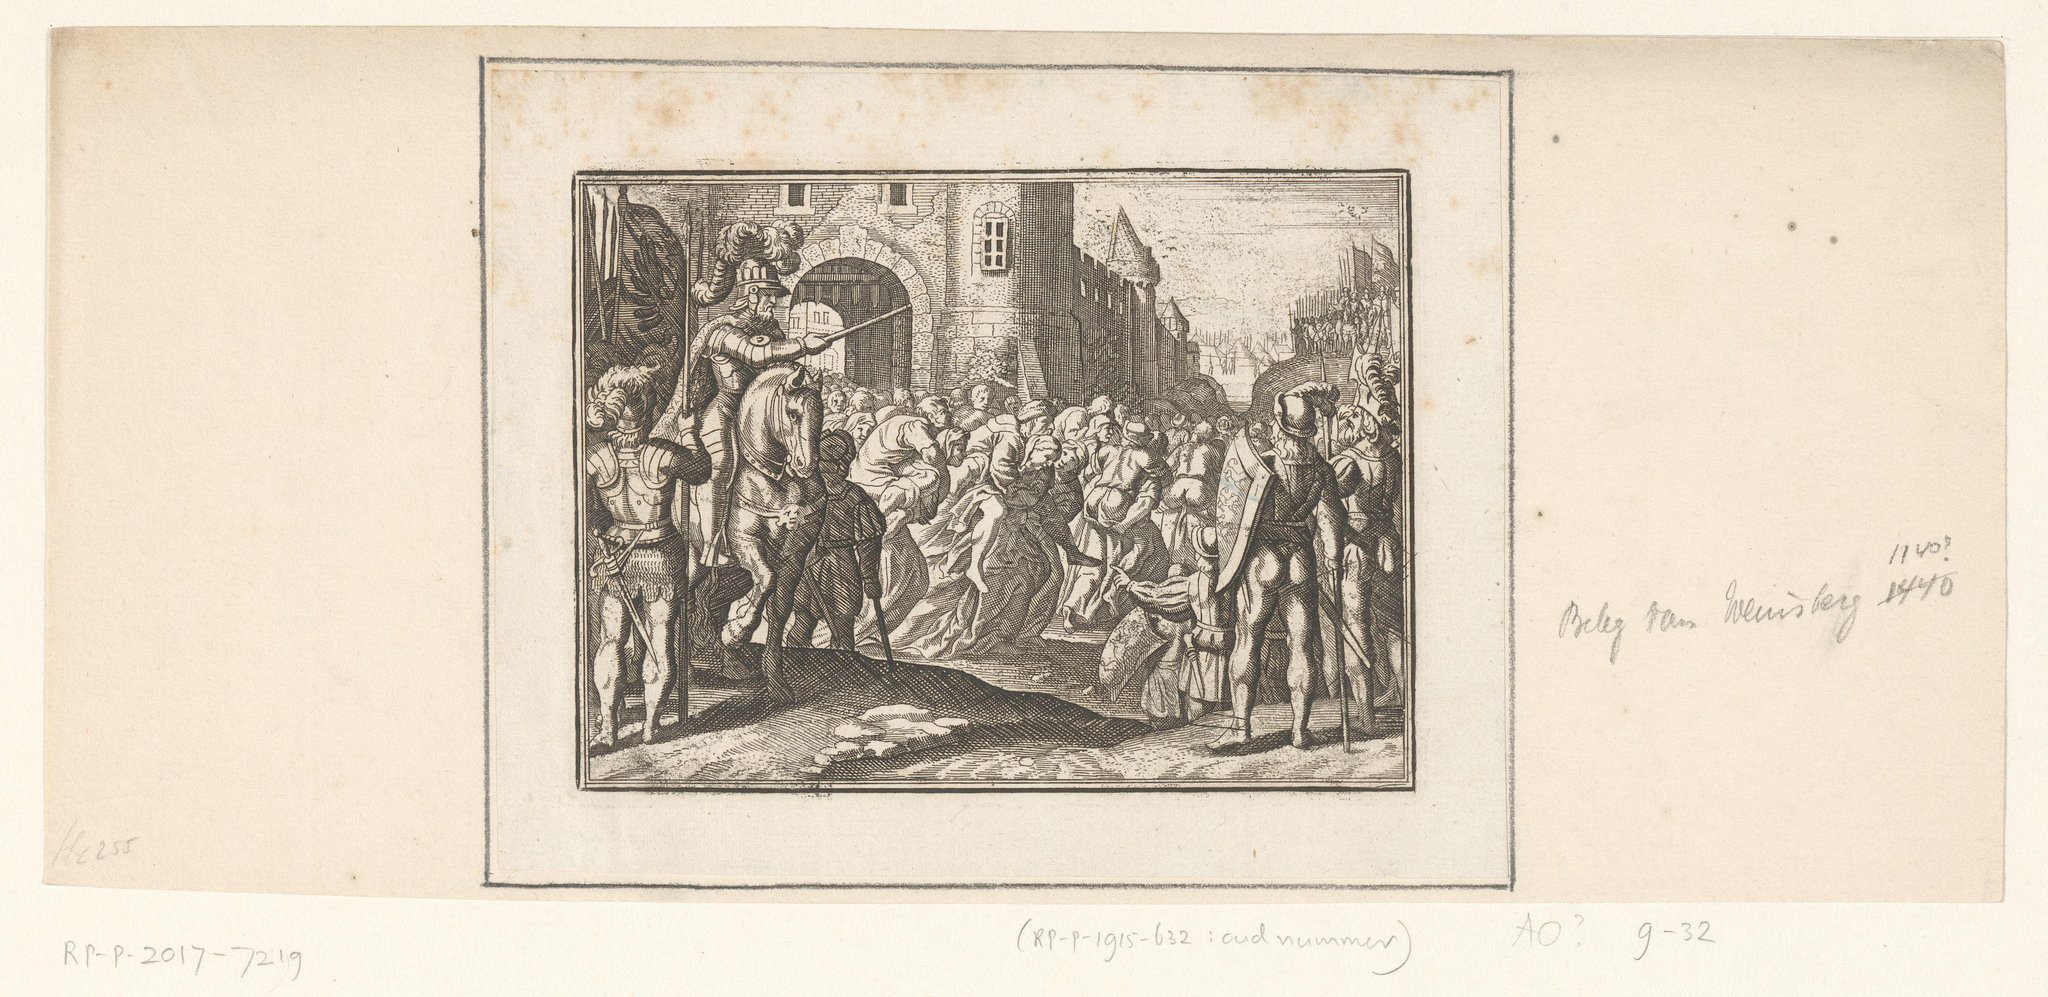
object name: print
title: De vrouwen van Weinsberg dragen hun mannen op de rug de stad uit, 1140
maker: Anonymous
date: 1600-1750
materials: paper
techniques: etching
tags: capture of city (after the siege), carrying a person on one's back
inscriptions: collector's mark: Lugt 2228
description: De keizer (Rooms-koning Koenraad III) heeft de stad Winbergen (Weinsberg) ingenomen, 21 december 1140. De stedelingen worden verzocht de stad te verlaten en mogen meenemen wat ze kunnen dragen. De vrouwen van Winbergen kiezen ervoor hun mannen op de rug de stad uit te dragen zodat deze niet gevangen genomen worden.